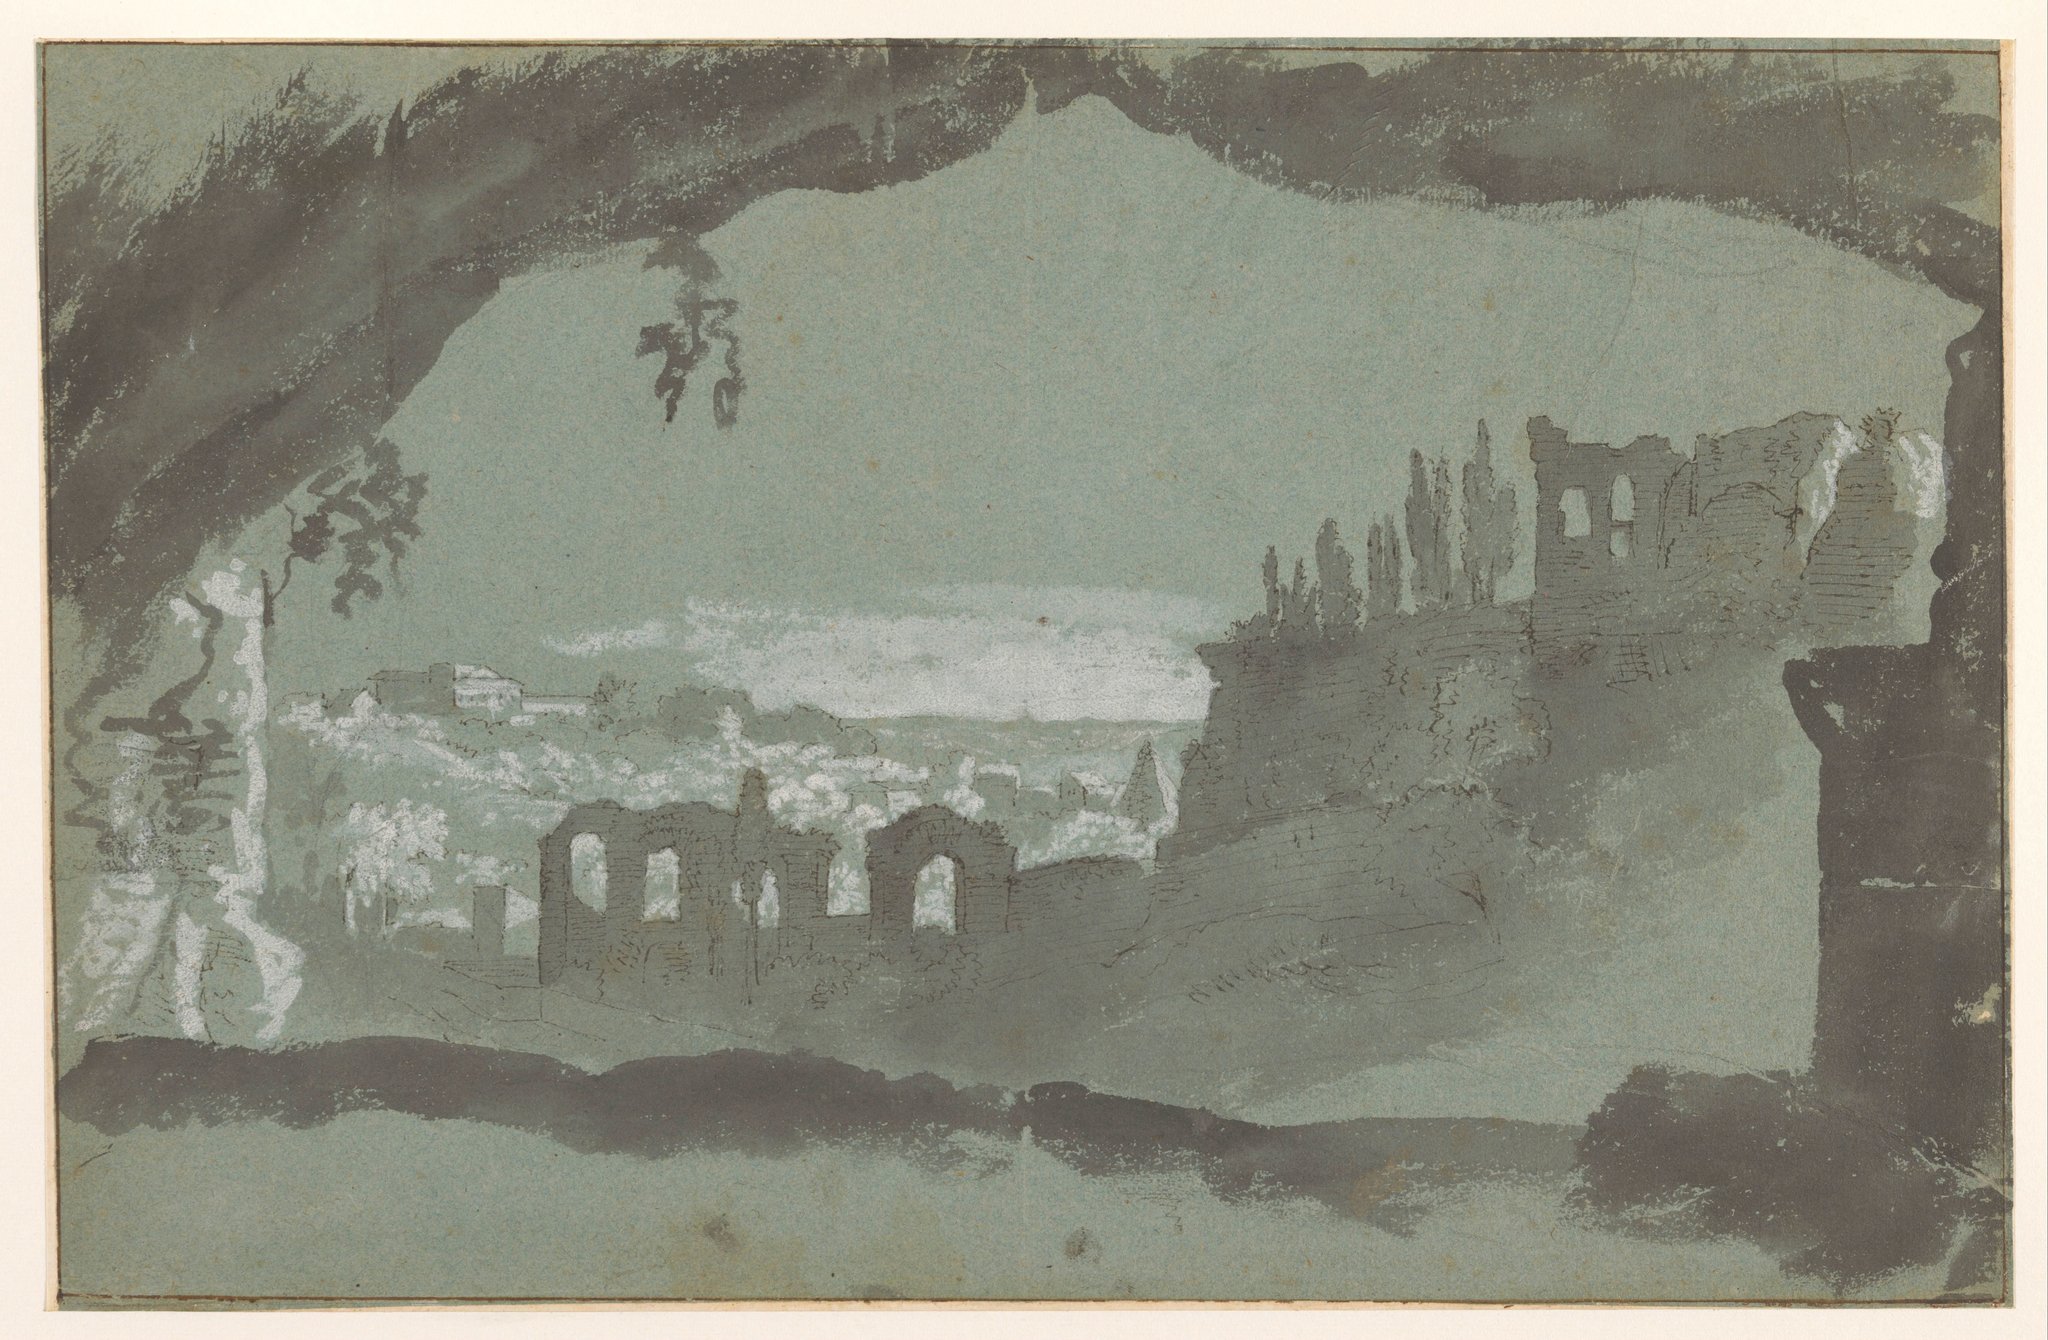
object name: drawing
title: Gezicht op de ruïnes van het paleis op de Palatijn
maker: Anonymous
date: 1700-1800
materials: ink, paper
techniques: brush, pen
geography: rome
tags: landscape with ruins, rome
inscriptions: collector's mark, verso, lower centre: Lugt 2228, annotation, verso, lower right, pencil: ‘Paysage avec ruines’, stamp, verso, lower right, purple ink: ‘douane centrale / exportation / Paris’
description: Gezicht op de ruïnes van het paleis op de Palatijn, links tot Santa Saba, rechts tot de Porta en de pyramide van Cestius, Rome.